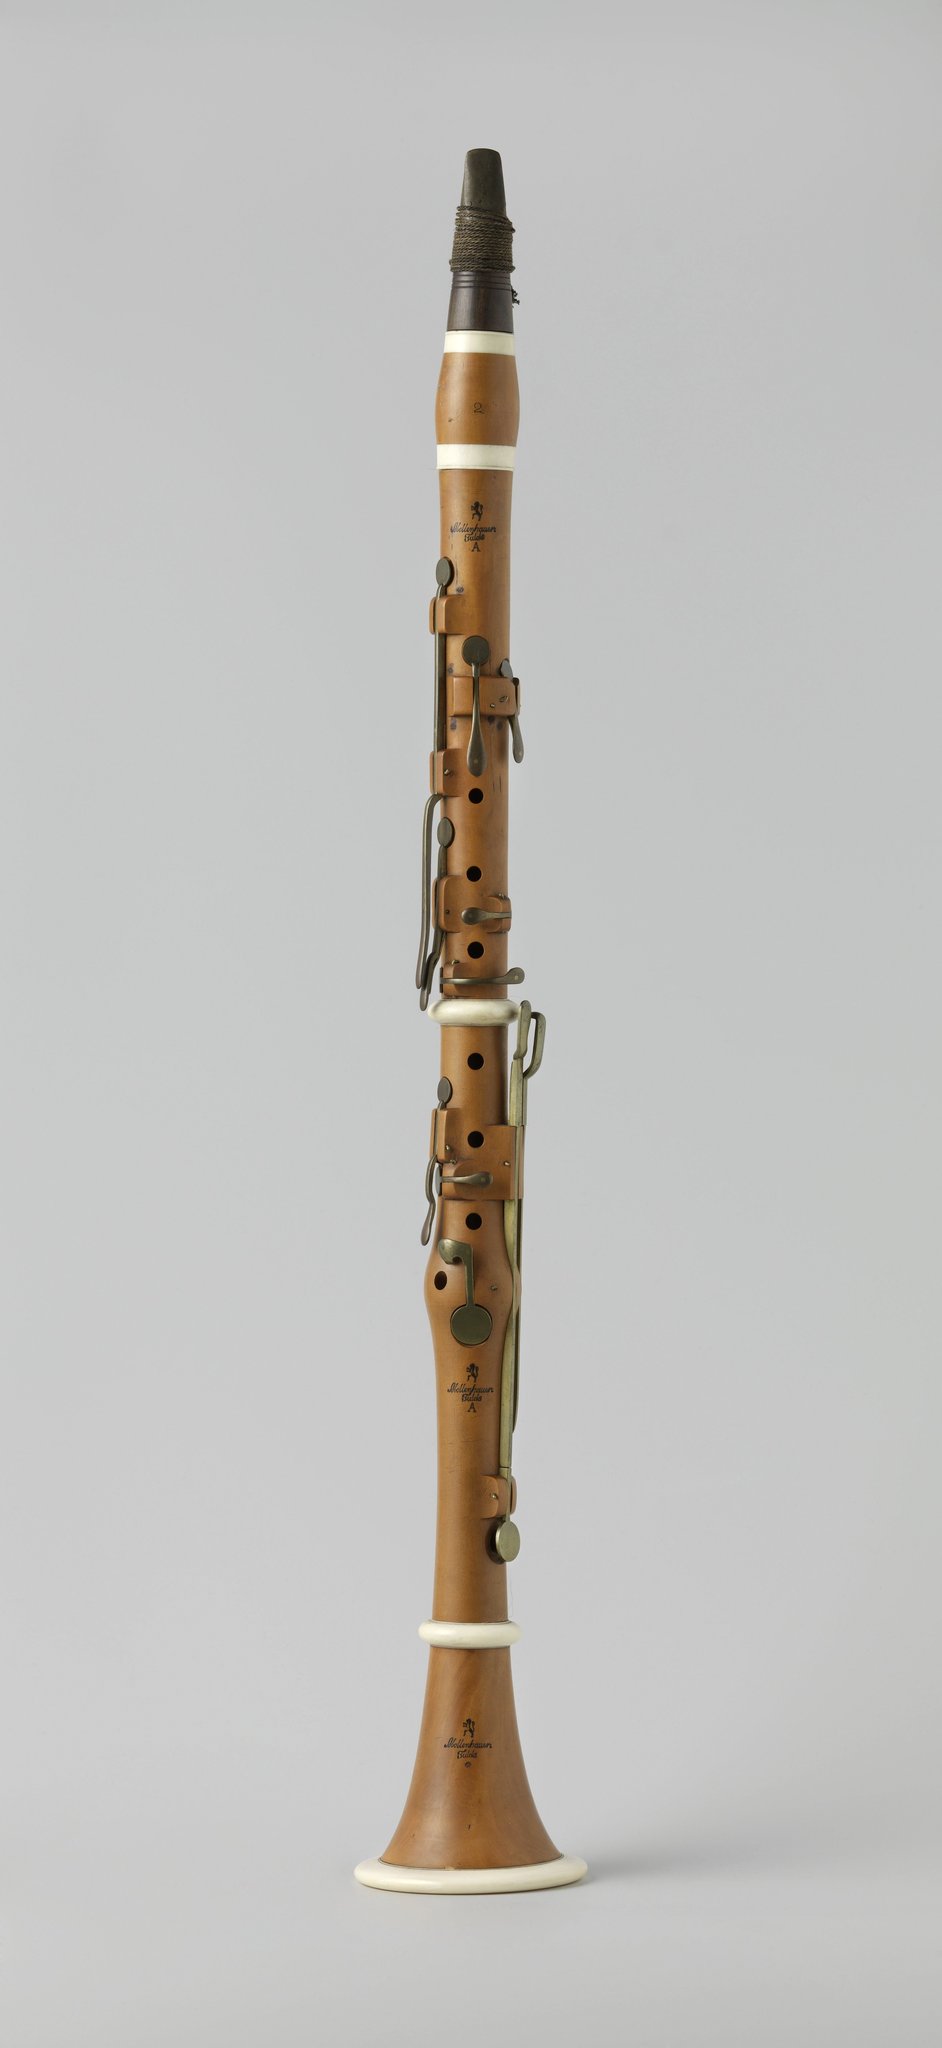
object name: musical instrument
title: Clarinet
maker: johann andreas mollenhauer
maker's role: musical instrument maker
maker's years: 1798-1871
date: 1840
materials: wood, brass, ivory, silver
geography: fulda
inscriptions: mark, on the upper and lower joint and bell, stamped: ‘Mollenhauer/ Fulda’ [lion rampant ]/ Mollenhauer/ Fulda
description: A klarinet van palmhout. Gemerkt: Mollenhauer Fulda.